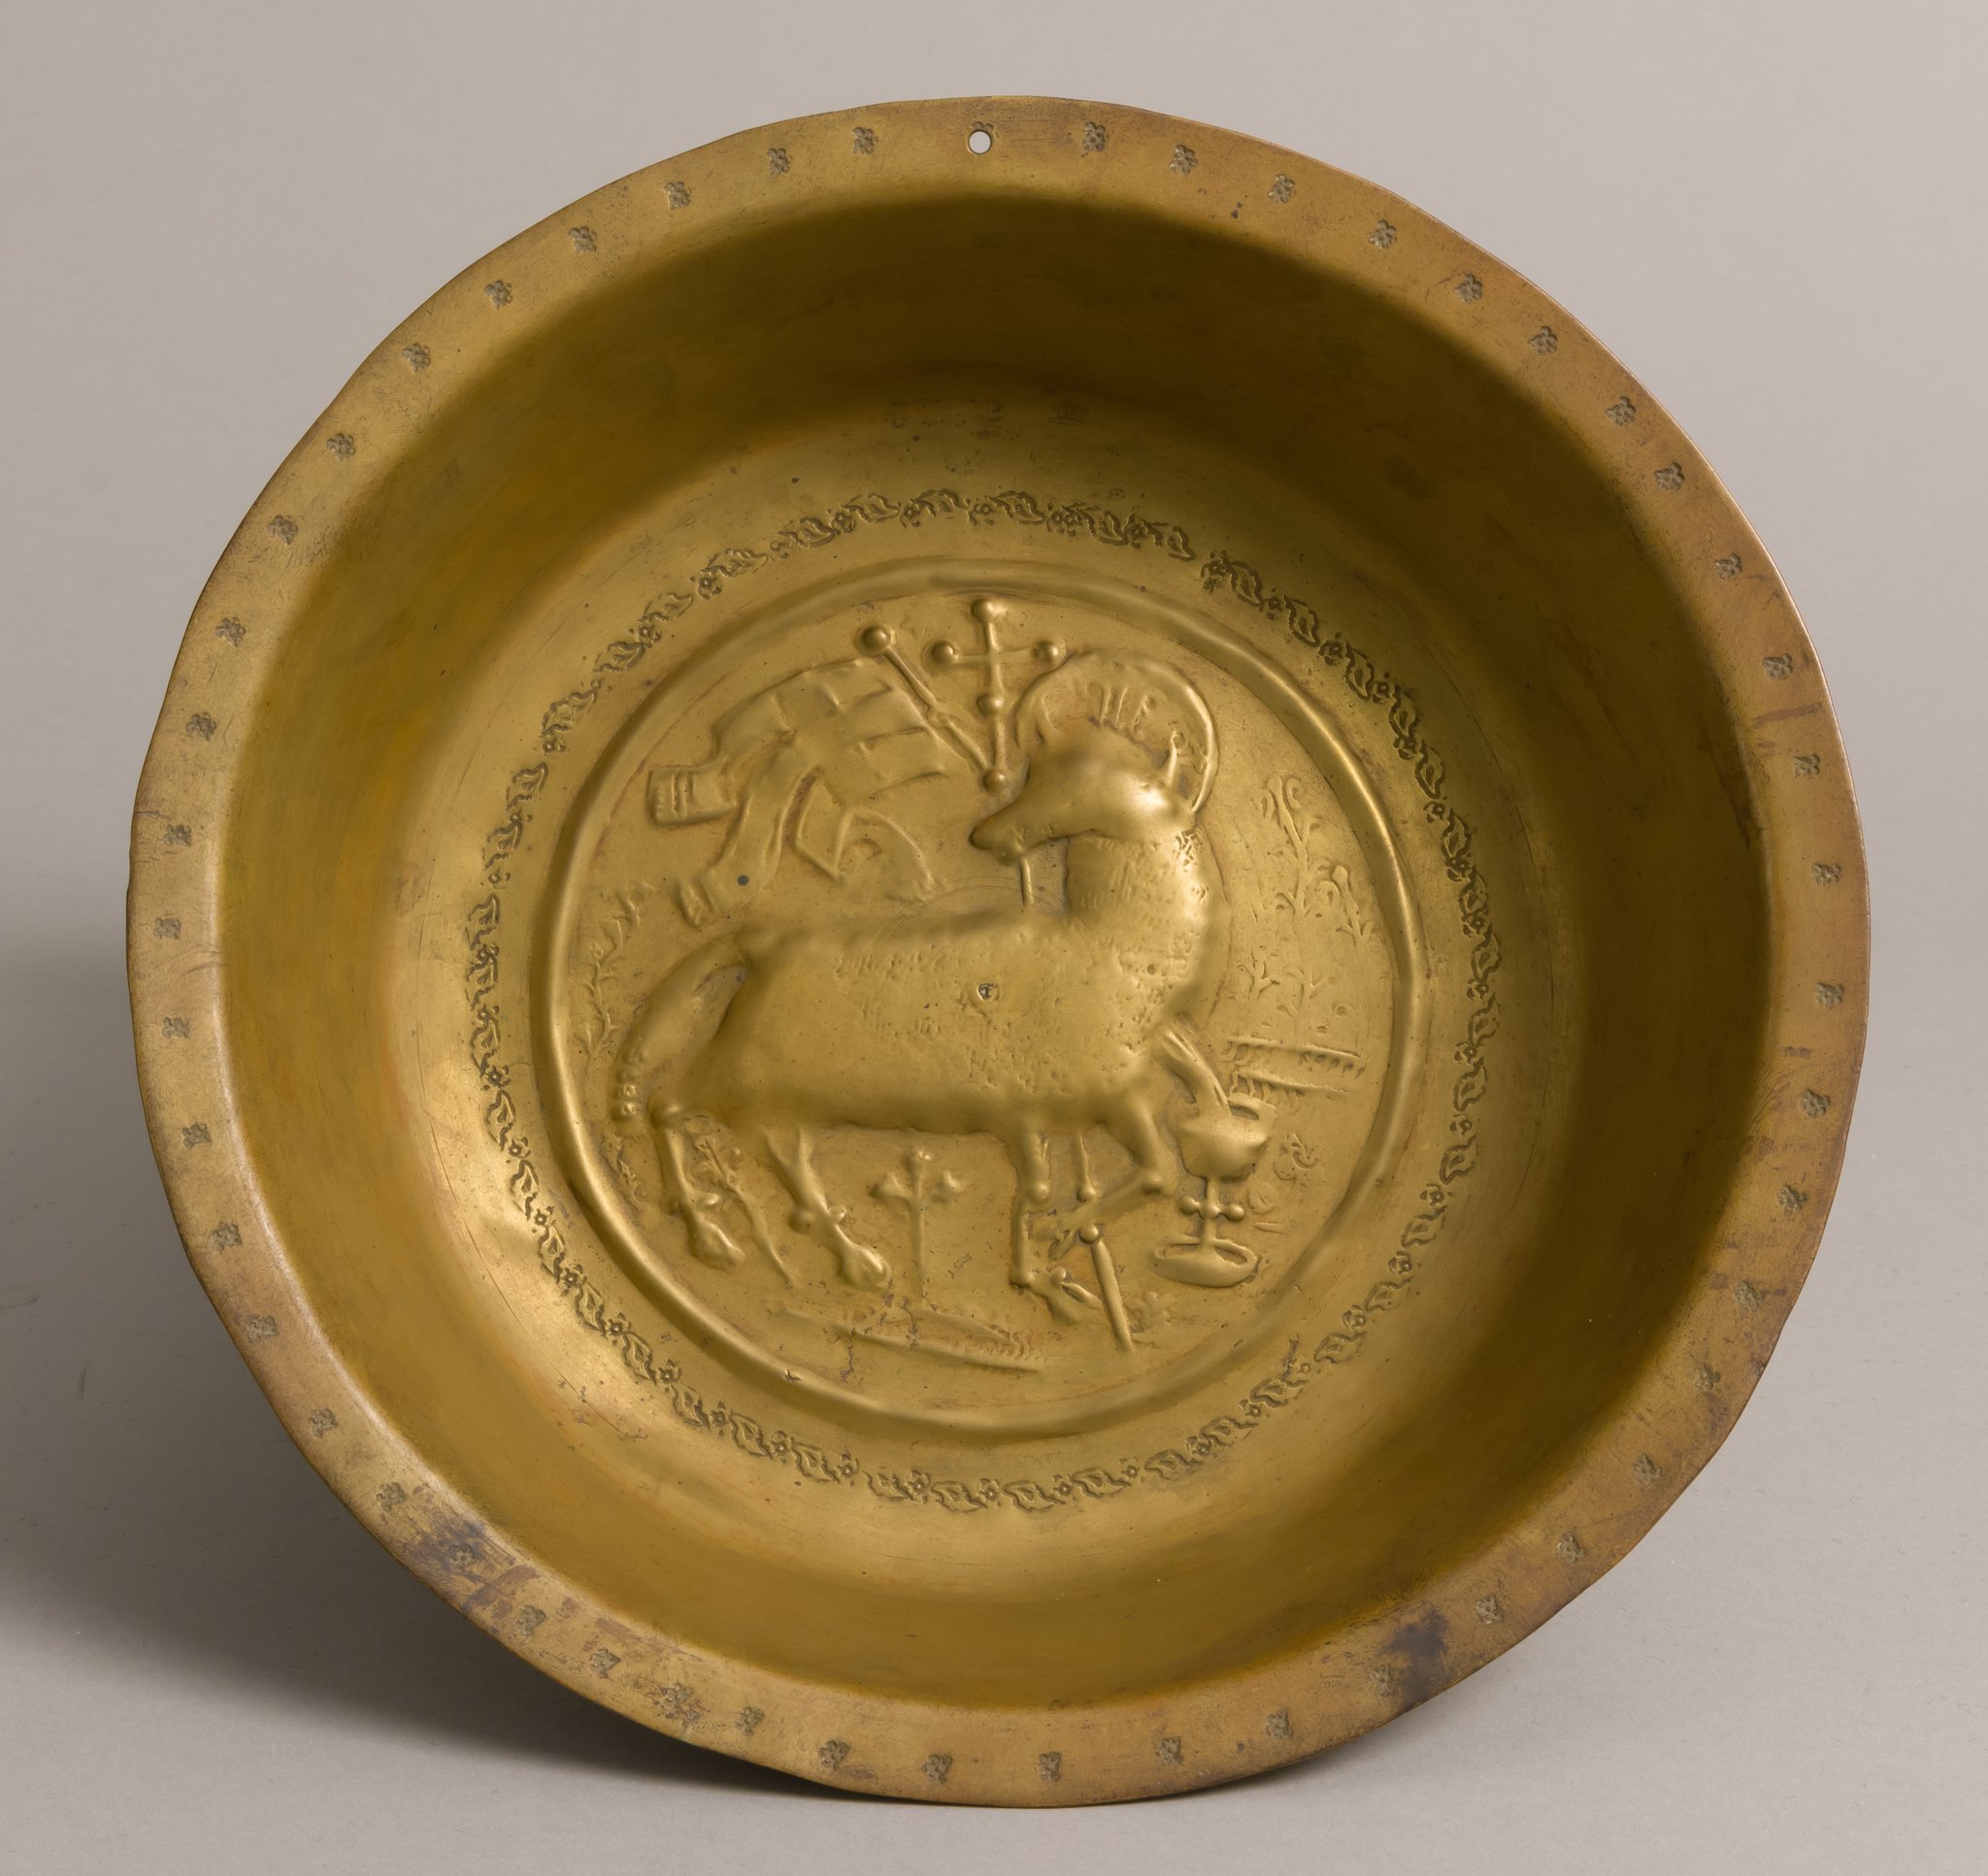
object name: dish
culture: german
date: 1501-1533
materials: brass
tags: animals